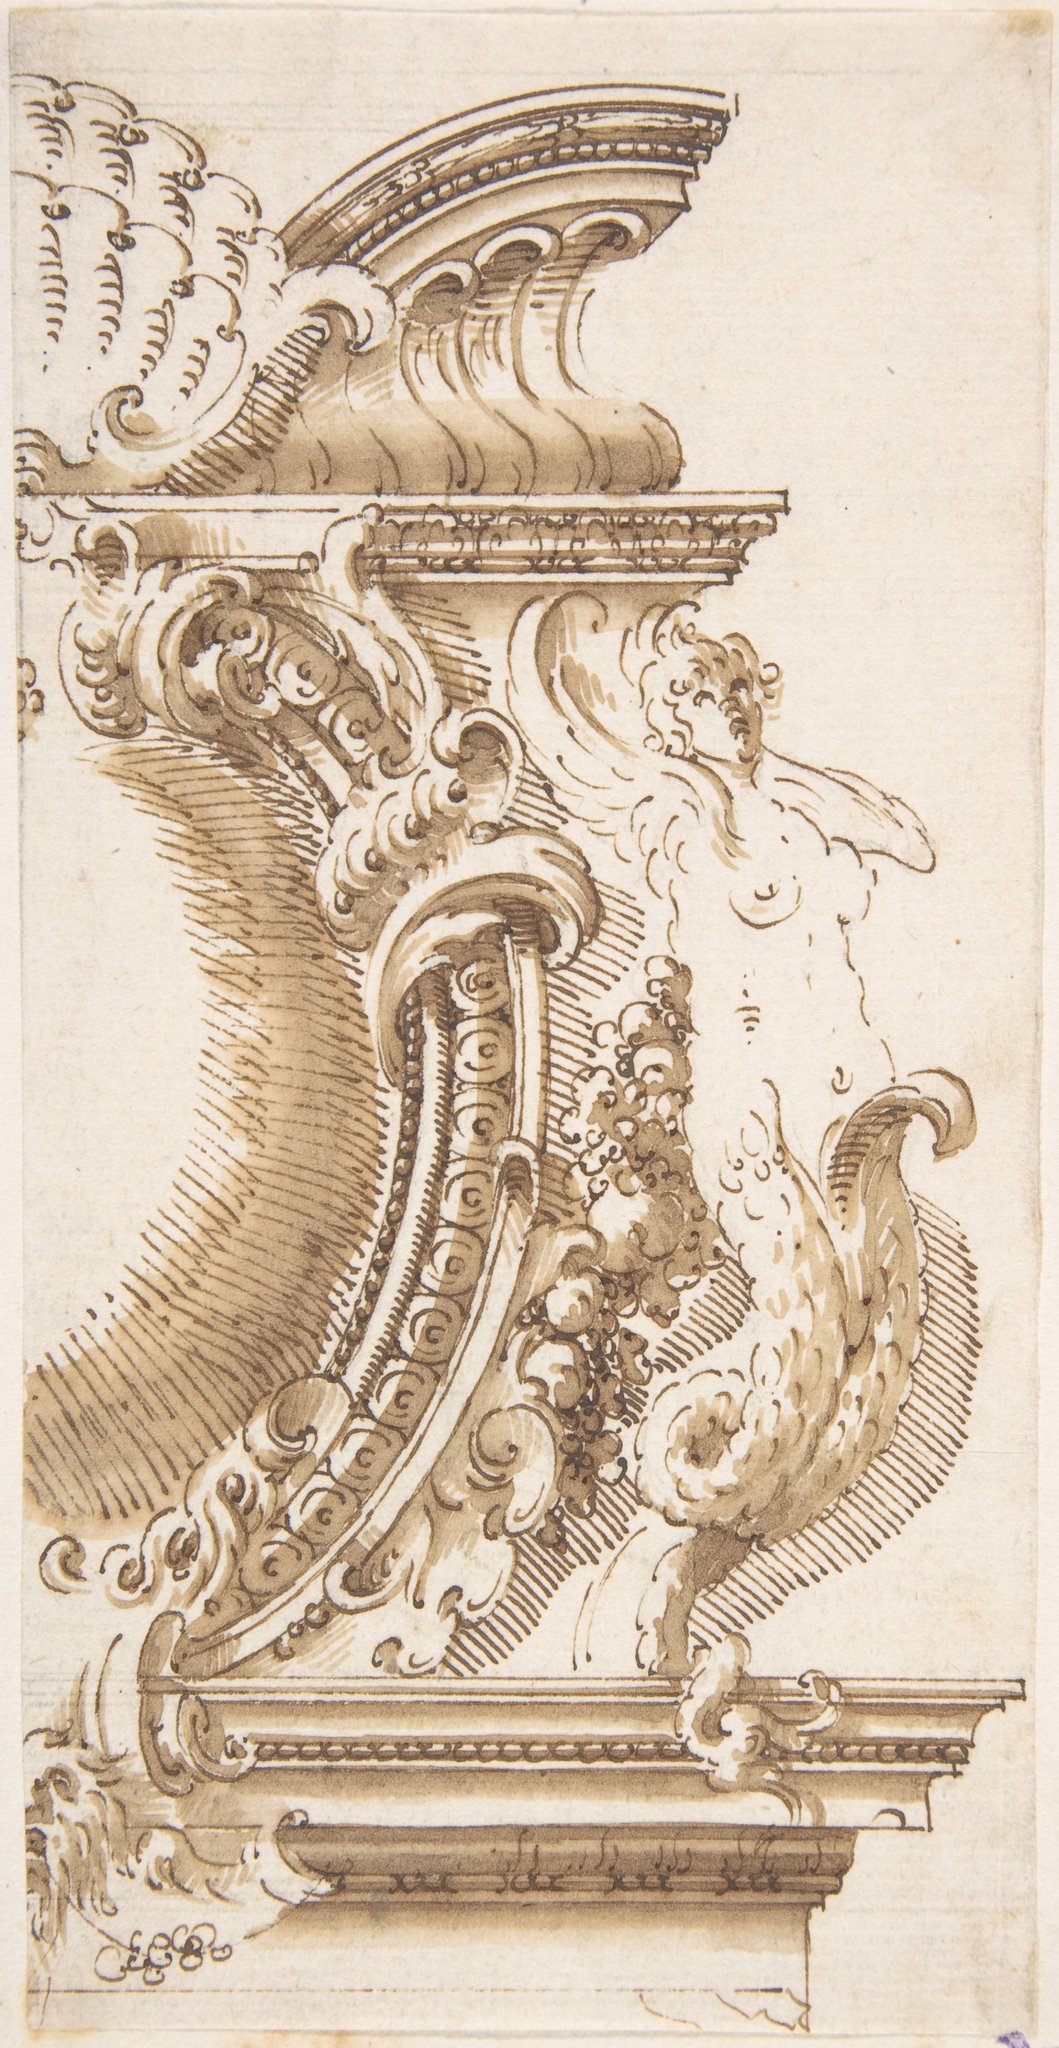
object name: drawing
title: Architectural Design with a Cartouche Flanked by a Siren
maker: anonymous, italian, 18th century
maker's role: artist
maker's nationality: italian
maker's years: 1700-1800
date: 1701-1800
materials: ink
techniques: pen, wash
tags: cartouches